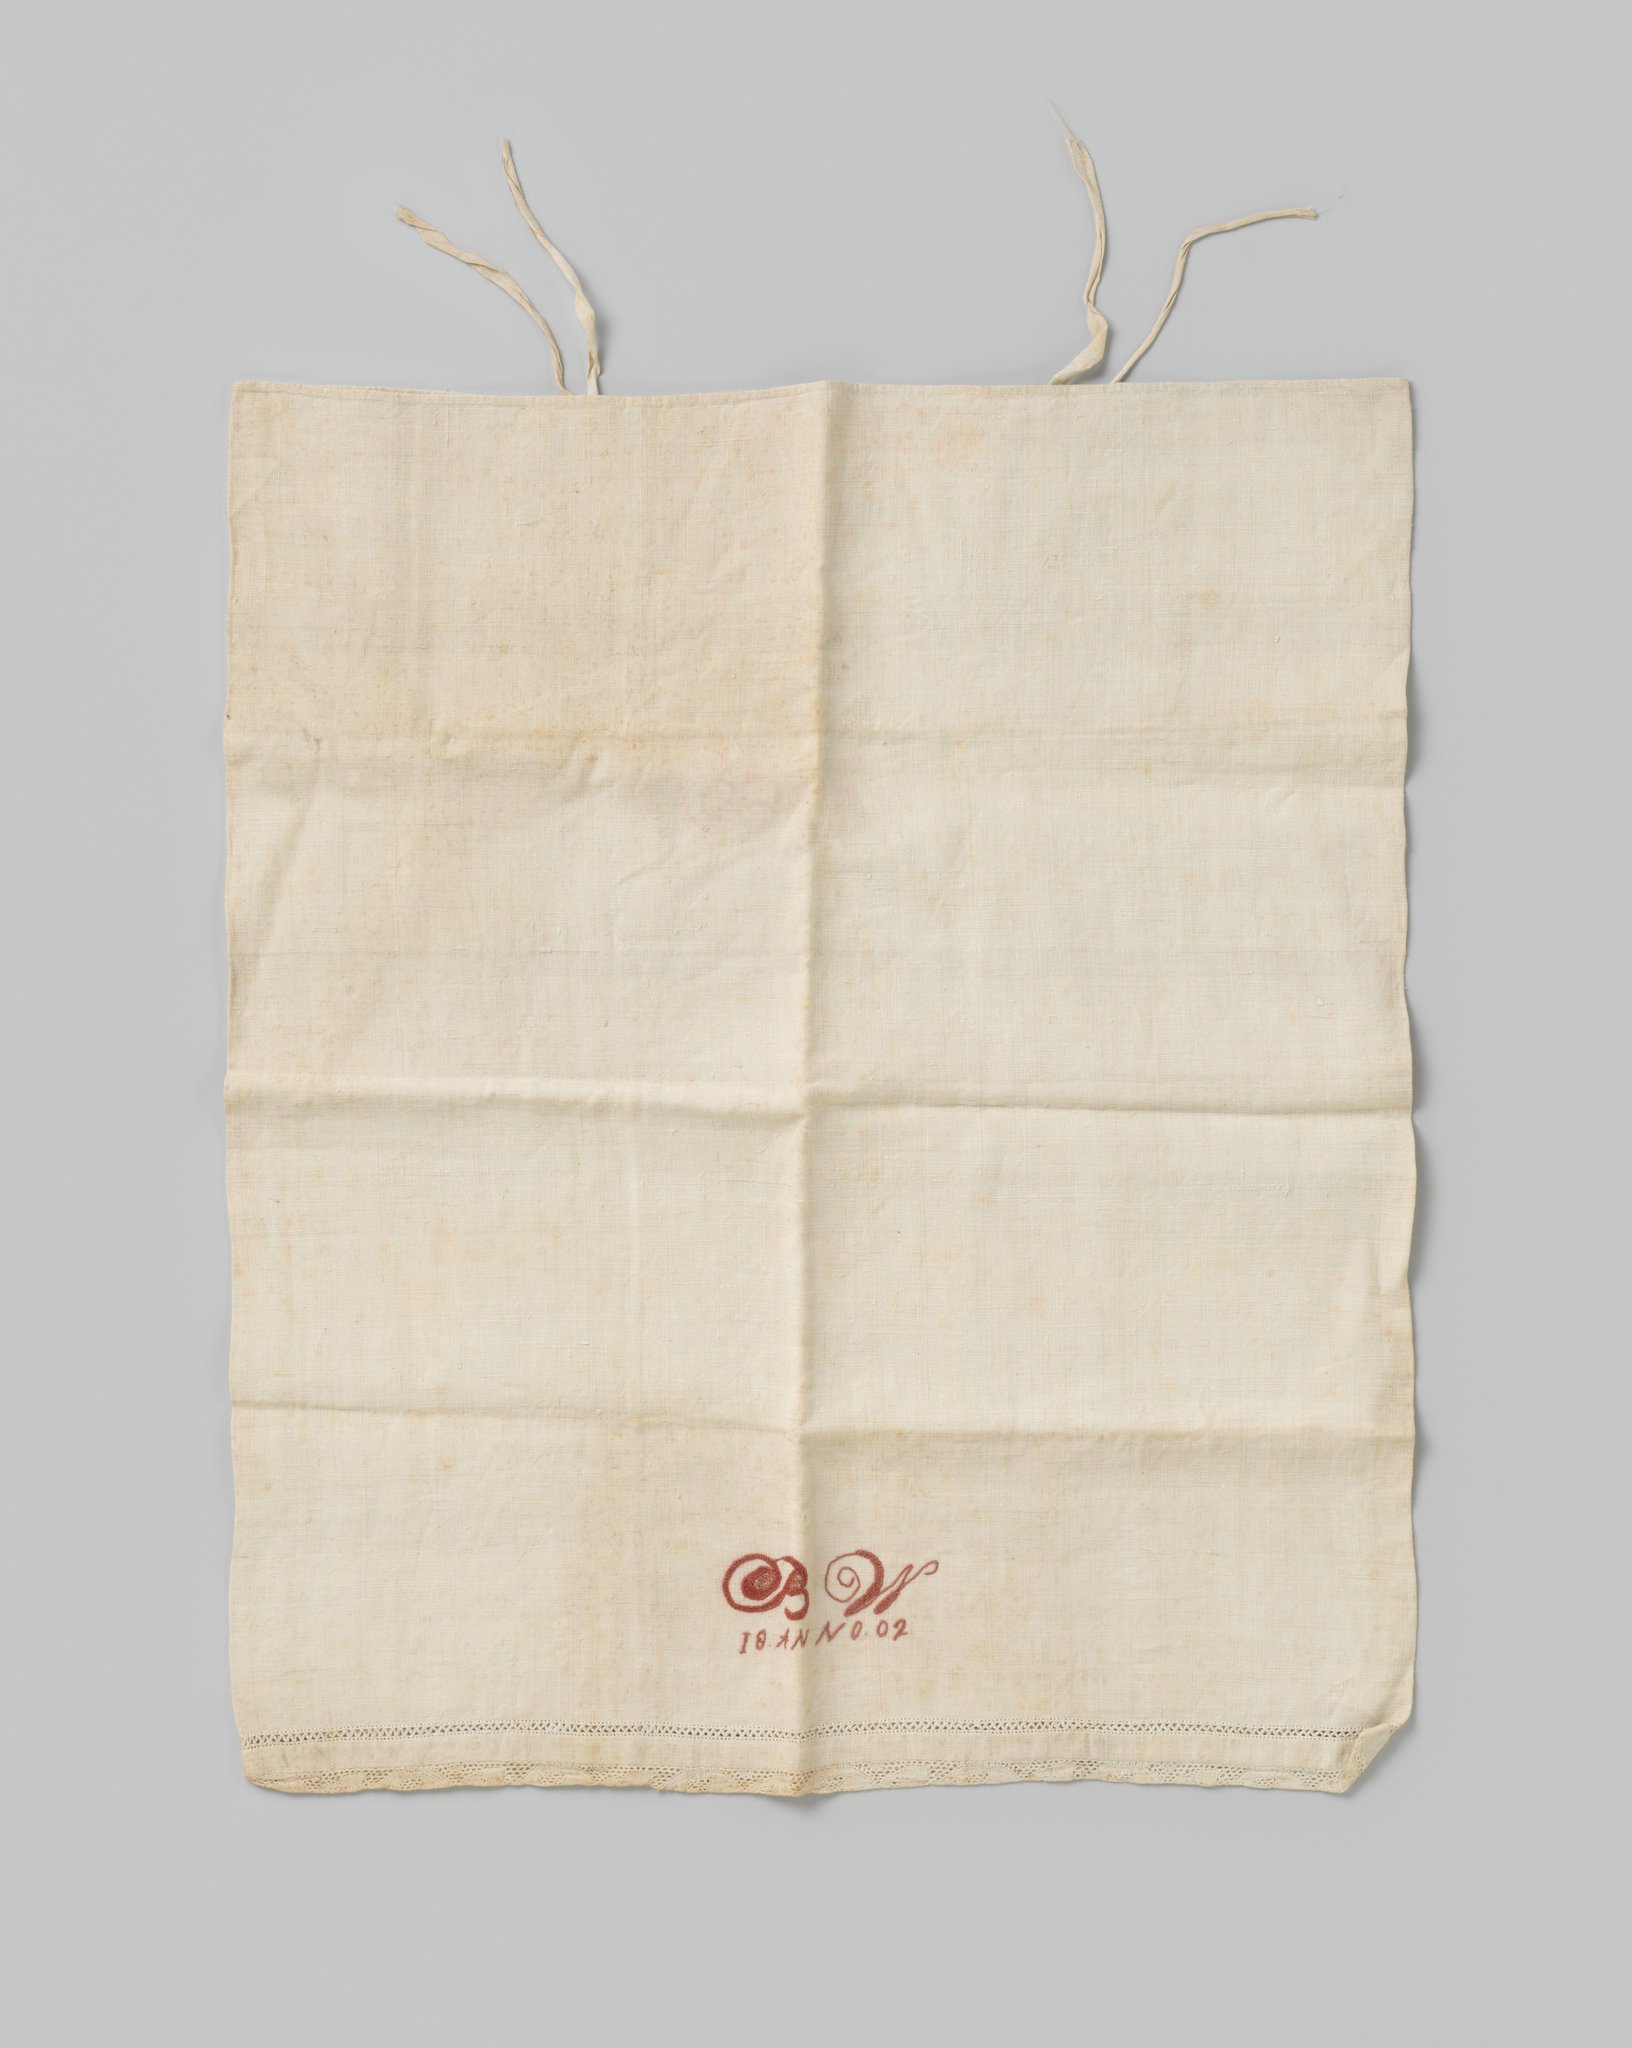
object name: sloop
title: Sloop van grof linnen met entre-deux van grove kloskant met slingerende rank met vruchten. 1802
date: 1852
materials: linen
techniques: lace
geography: netherlands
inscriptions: date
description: Sloop van grof linnen met entre-deux van grove kloskant met slingerende rank met vruchten. Nederland (?), 1802.